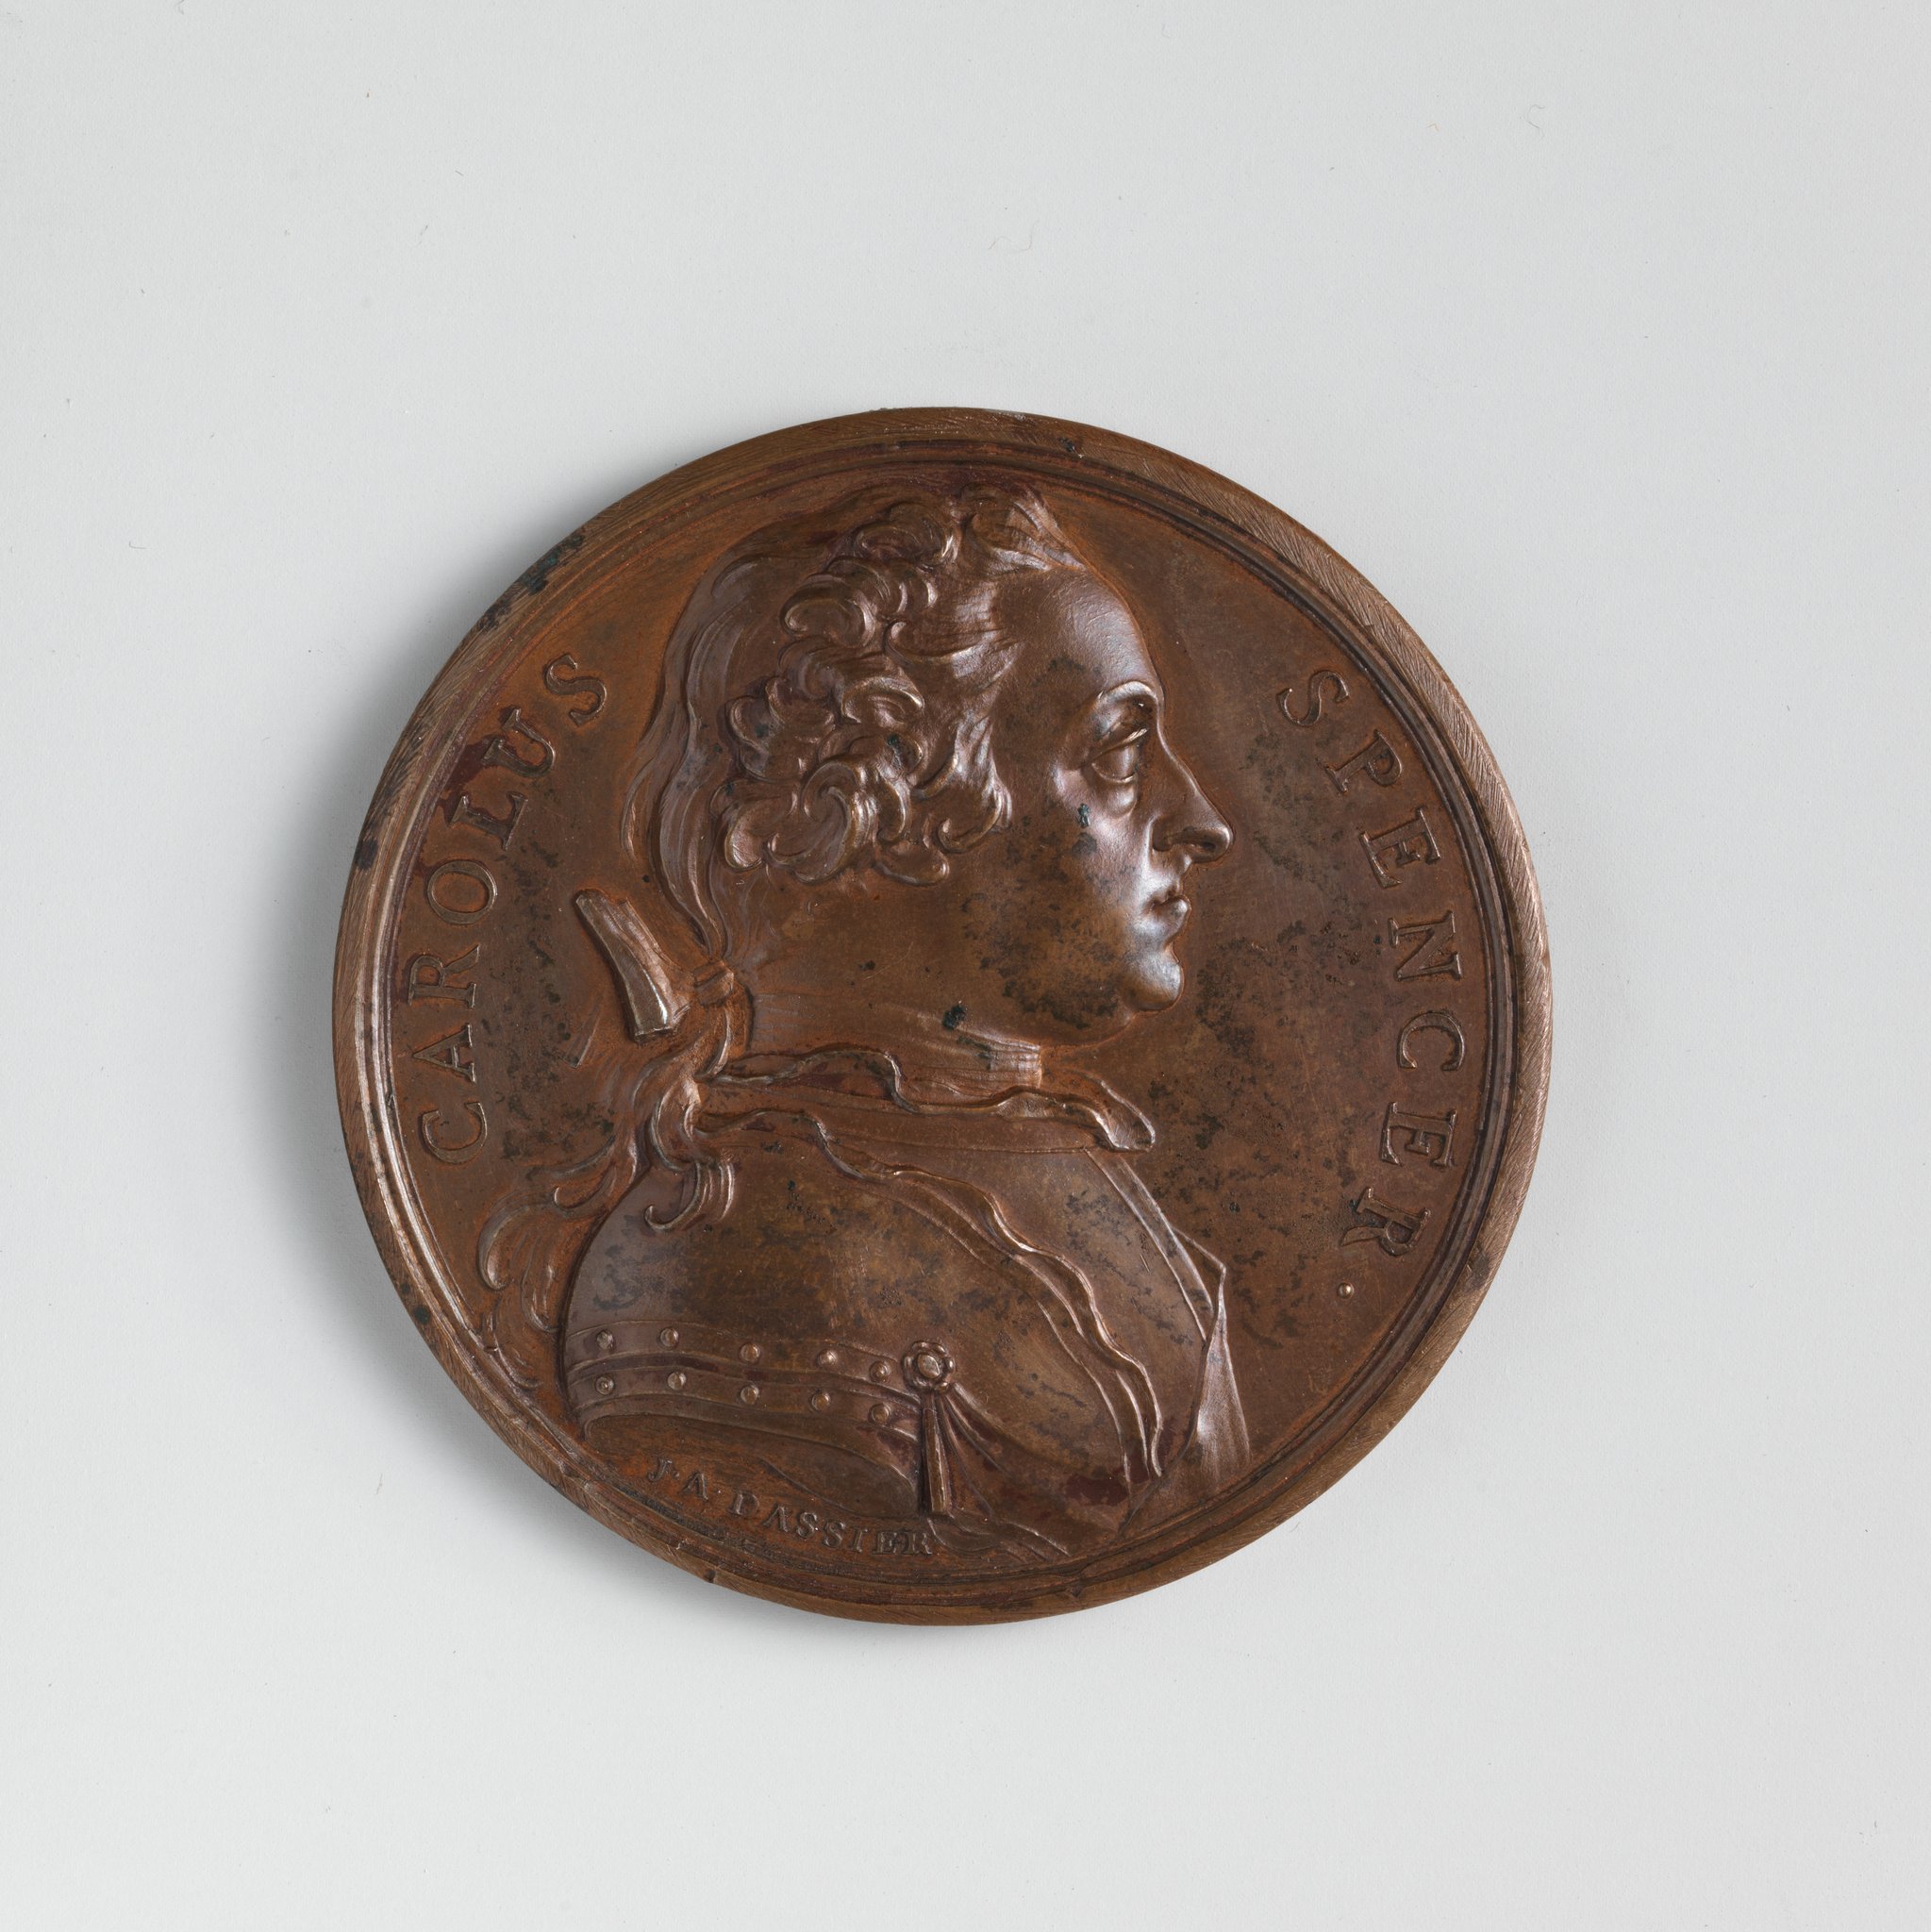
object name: medal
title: Charles Spencer, 3rd Duke of Marlborough (1706–1754)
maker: jacques-antoine dassier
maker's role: artist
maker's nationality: swiss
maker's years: 1715-1759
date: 1742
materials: bronze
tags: men,portraits